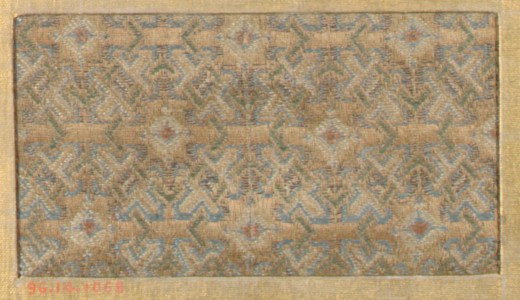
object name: piece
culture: japanese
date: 1701-1900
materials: silk